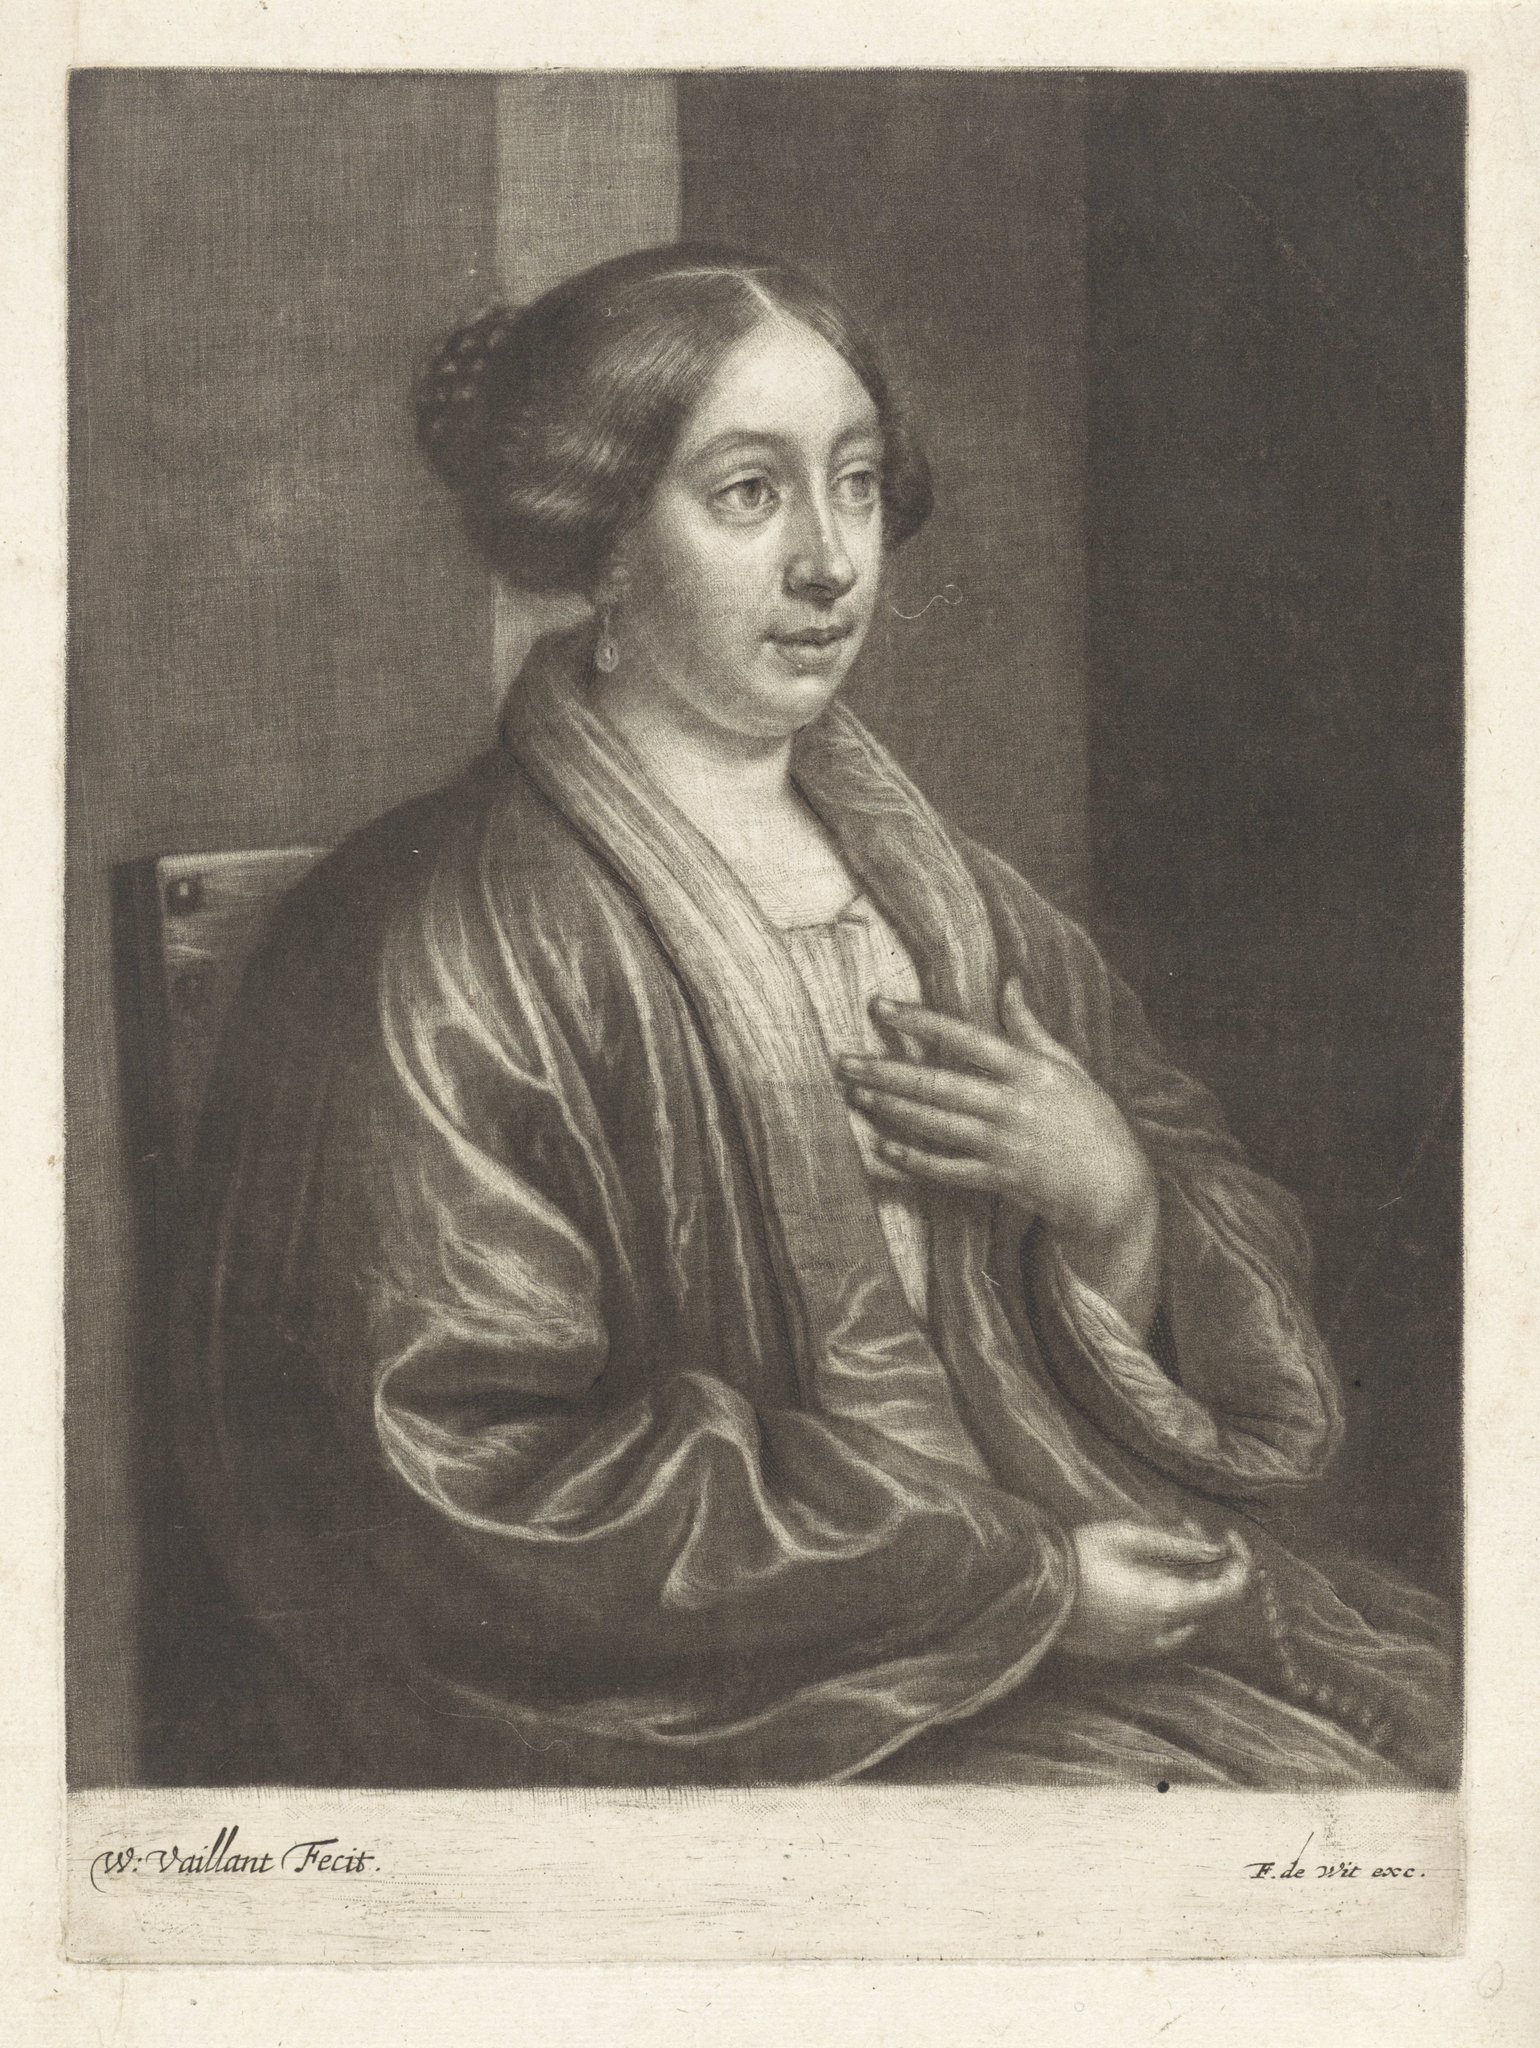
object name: print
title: Portret van een vrouw met een parelketting in de hand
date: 1658-1706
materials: paper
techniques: mezzotint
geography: amsterdam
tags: necklace (+ women's clothes)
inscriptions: collector's mark: Lugt 2228